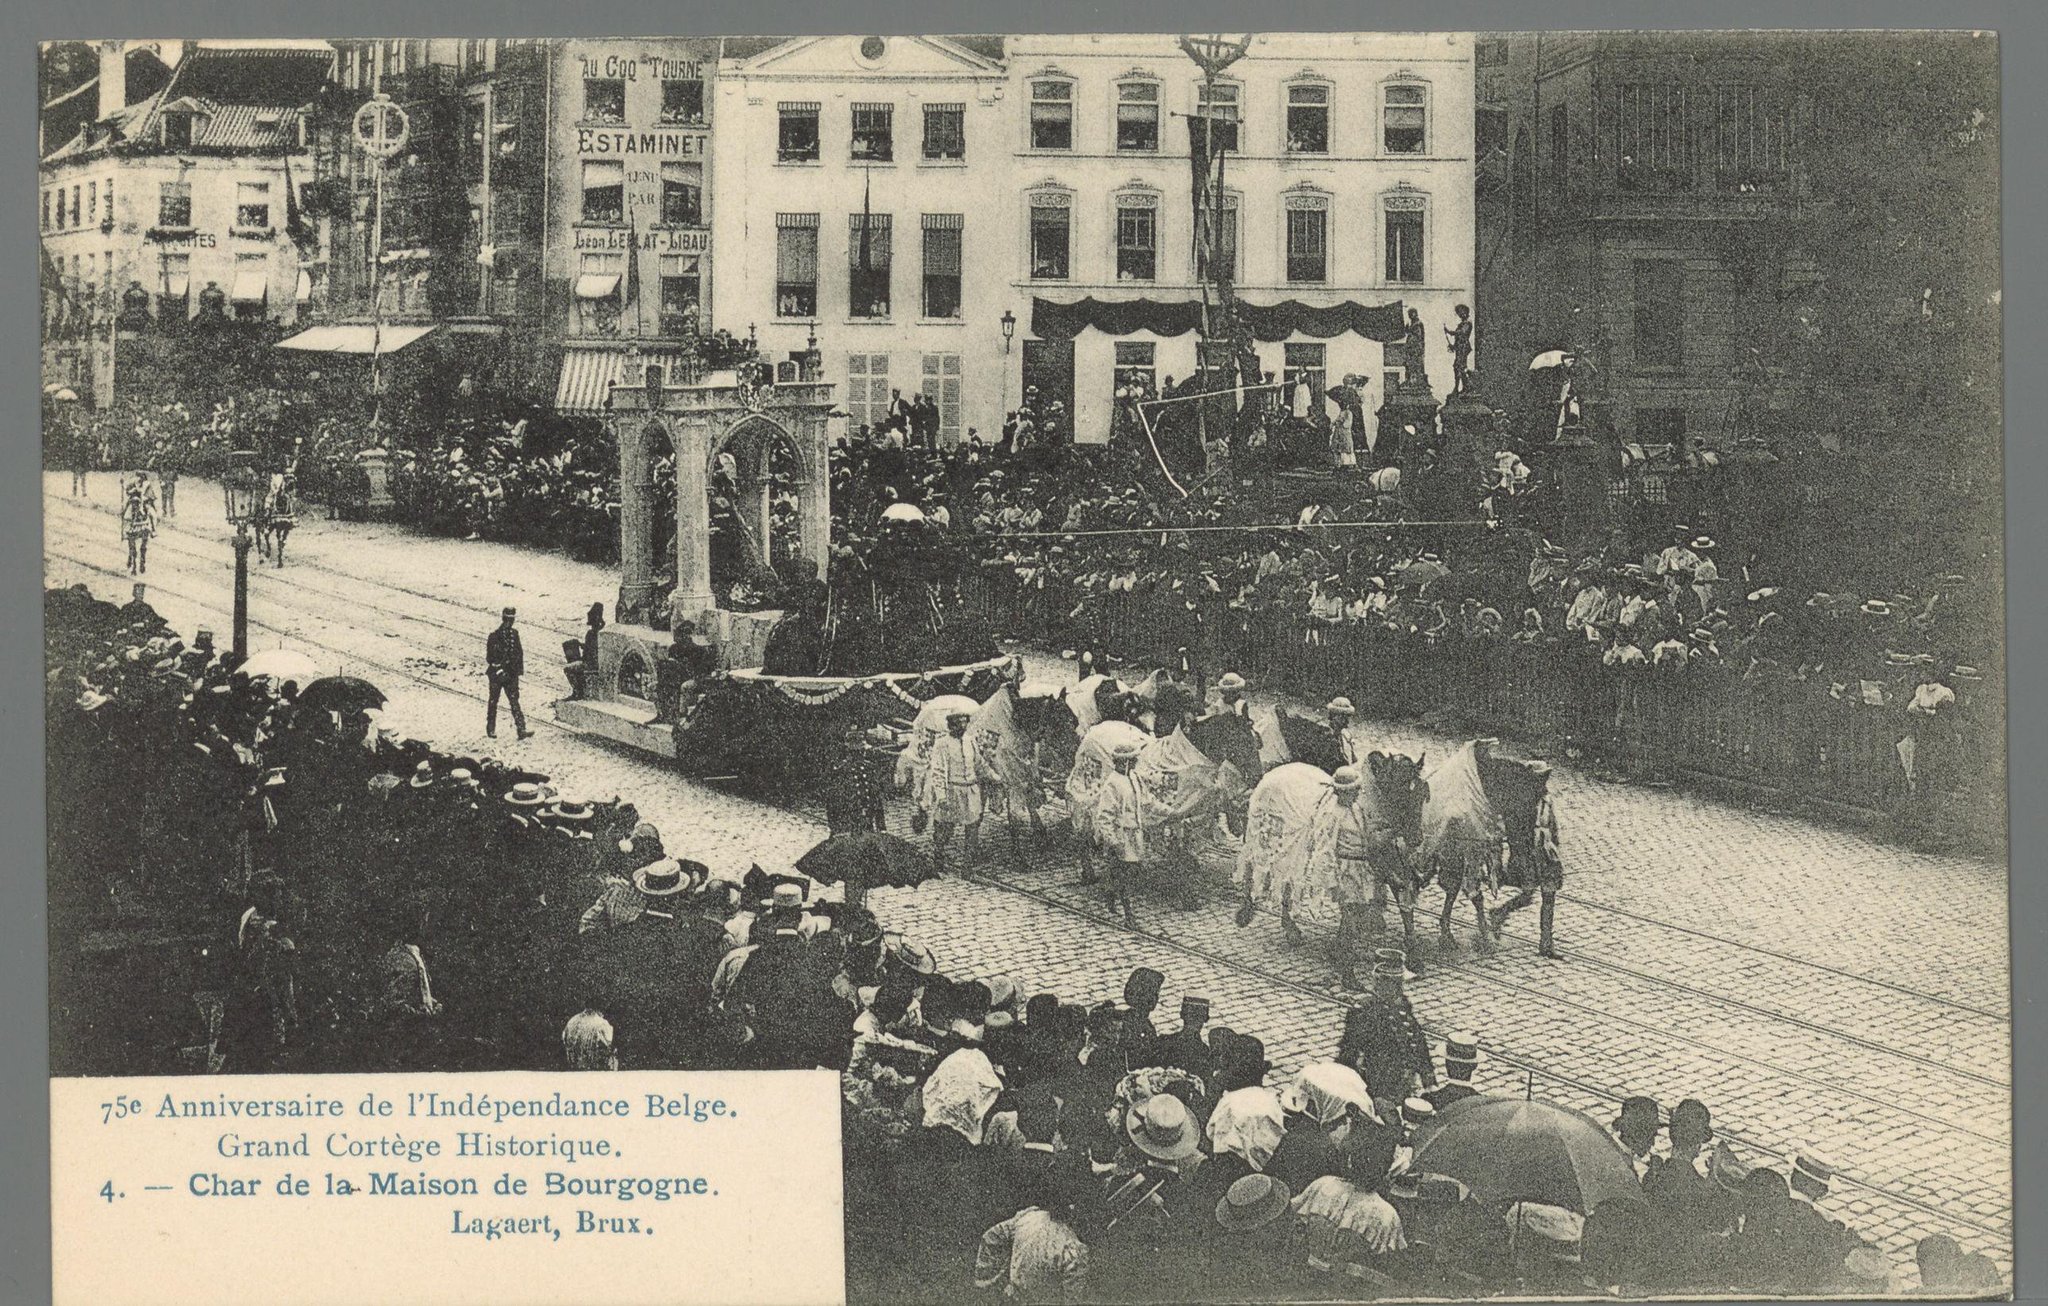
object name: ansichtkaart, prentbriefkaart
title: Char de la Maison de Bourgogne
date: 1905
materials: cardboard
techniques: photograph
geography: schaarbeek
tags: city-view, and landscape with man-made constructions (+ city(-scape) with figures, staffage), periodic celebrations, popular feasts, brussels